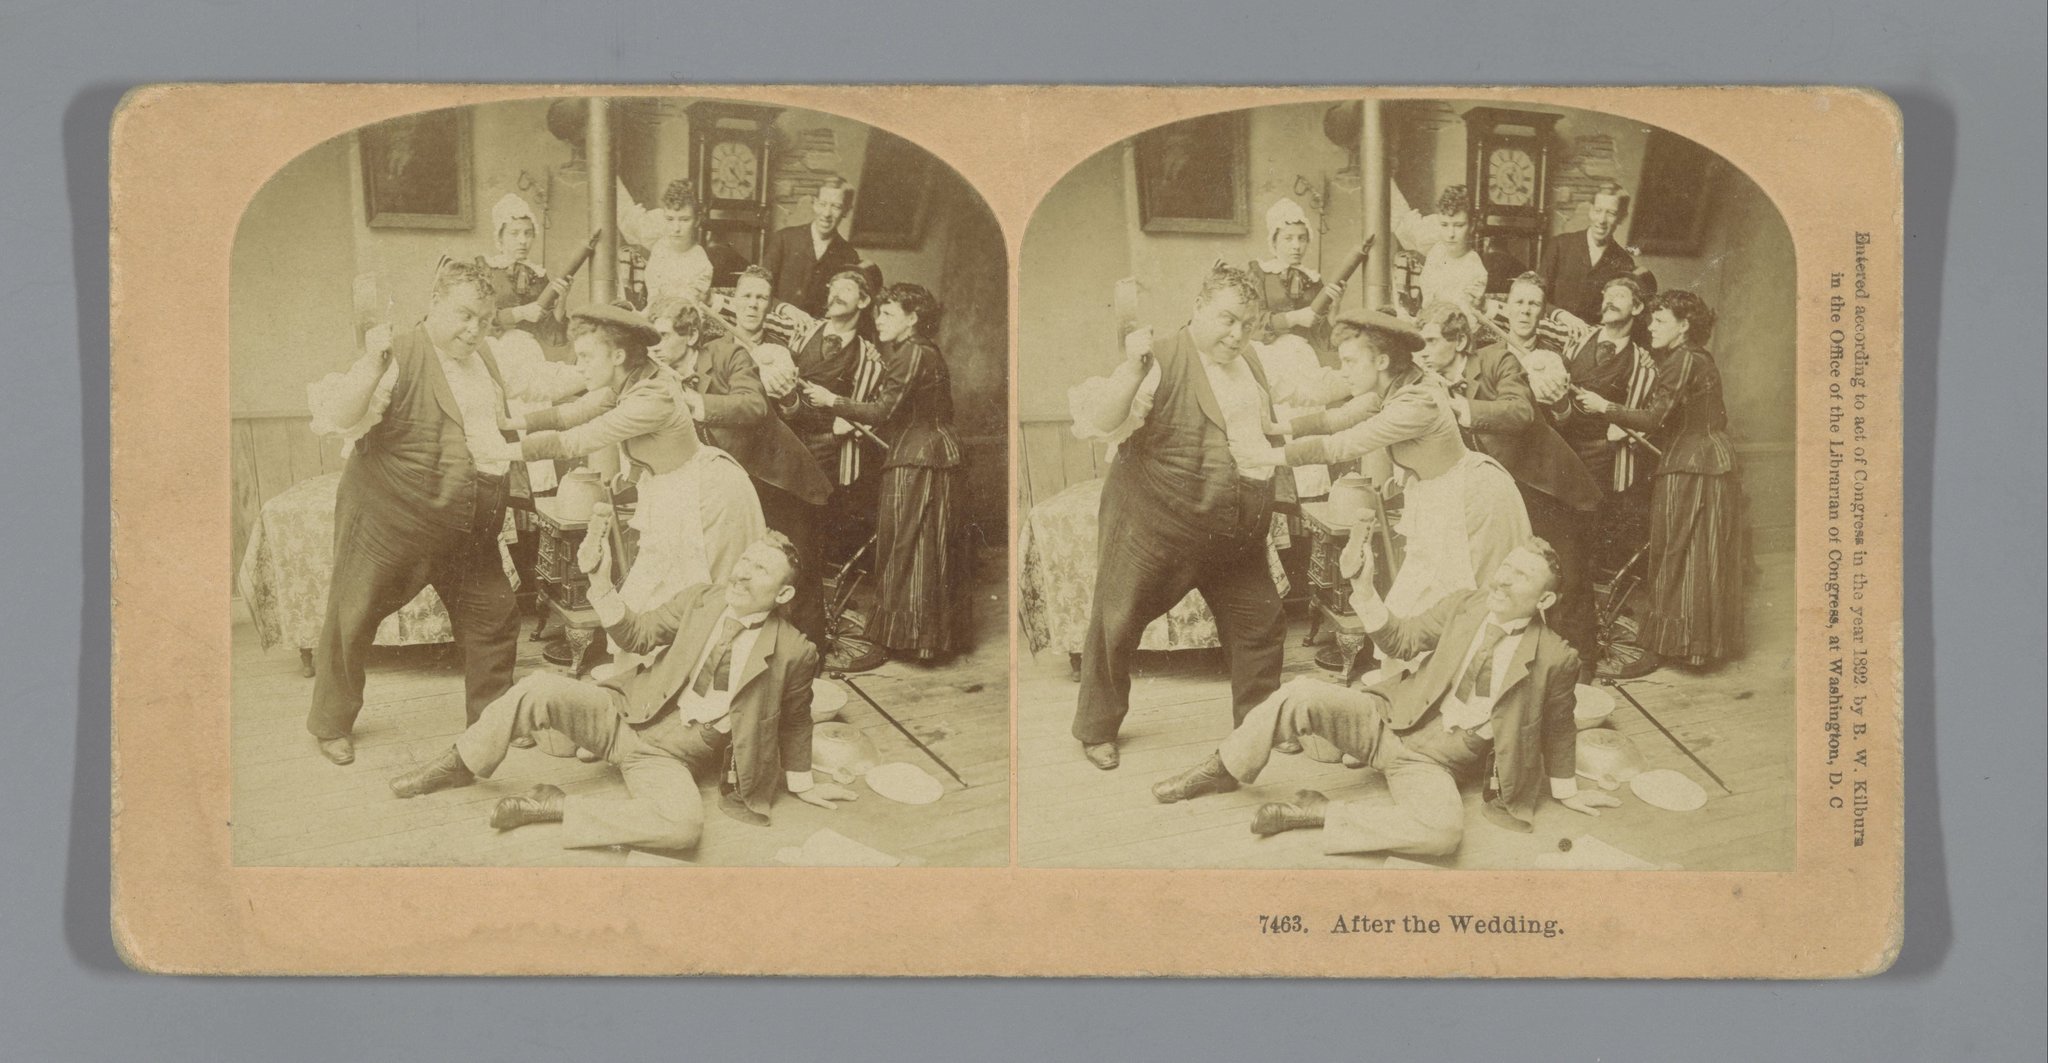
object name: stereograph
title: Vrouw tussen twee ruziemakende mannen met omstanders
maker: benjamin west kilburn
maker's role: fotograaf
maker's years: 1827-1909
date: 1892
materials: cardboard, photographic support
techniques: albumen print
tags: man and wife quarrelling, 'marriage à la mode'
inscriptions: : ‘Entered according to act of Congress in the year 1892 by B.W. Kilburn / in the Office of the Librarian of Congress, at Washington, D.C.’, company name: ‘Photographed and Published by / B.W. Kilburn, Littleton, N.H.’, number: ‘7483’